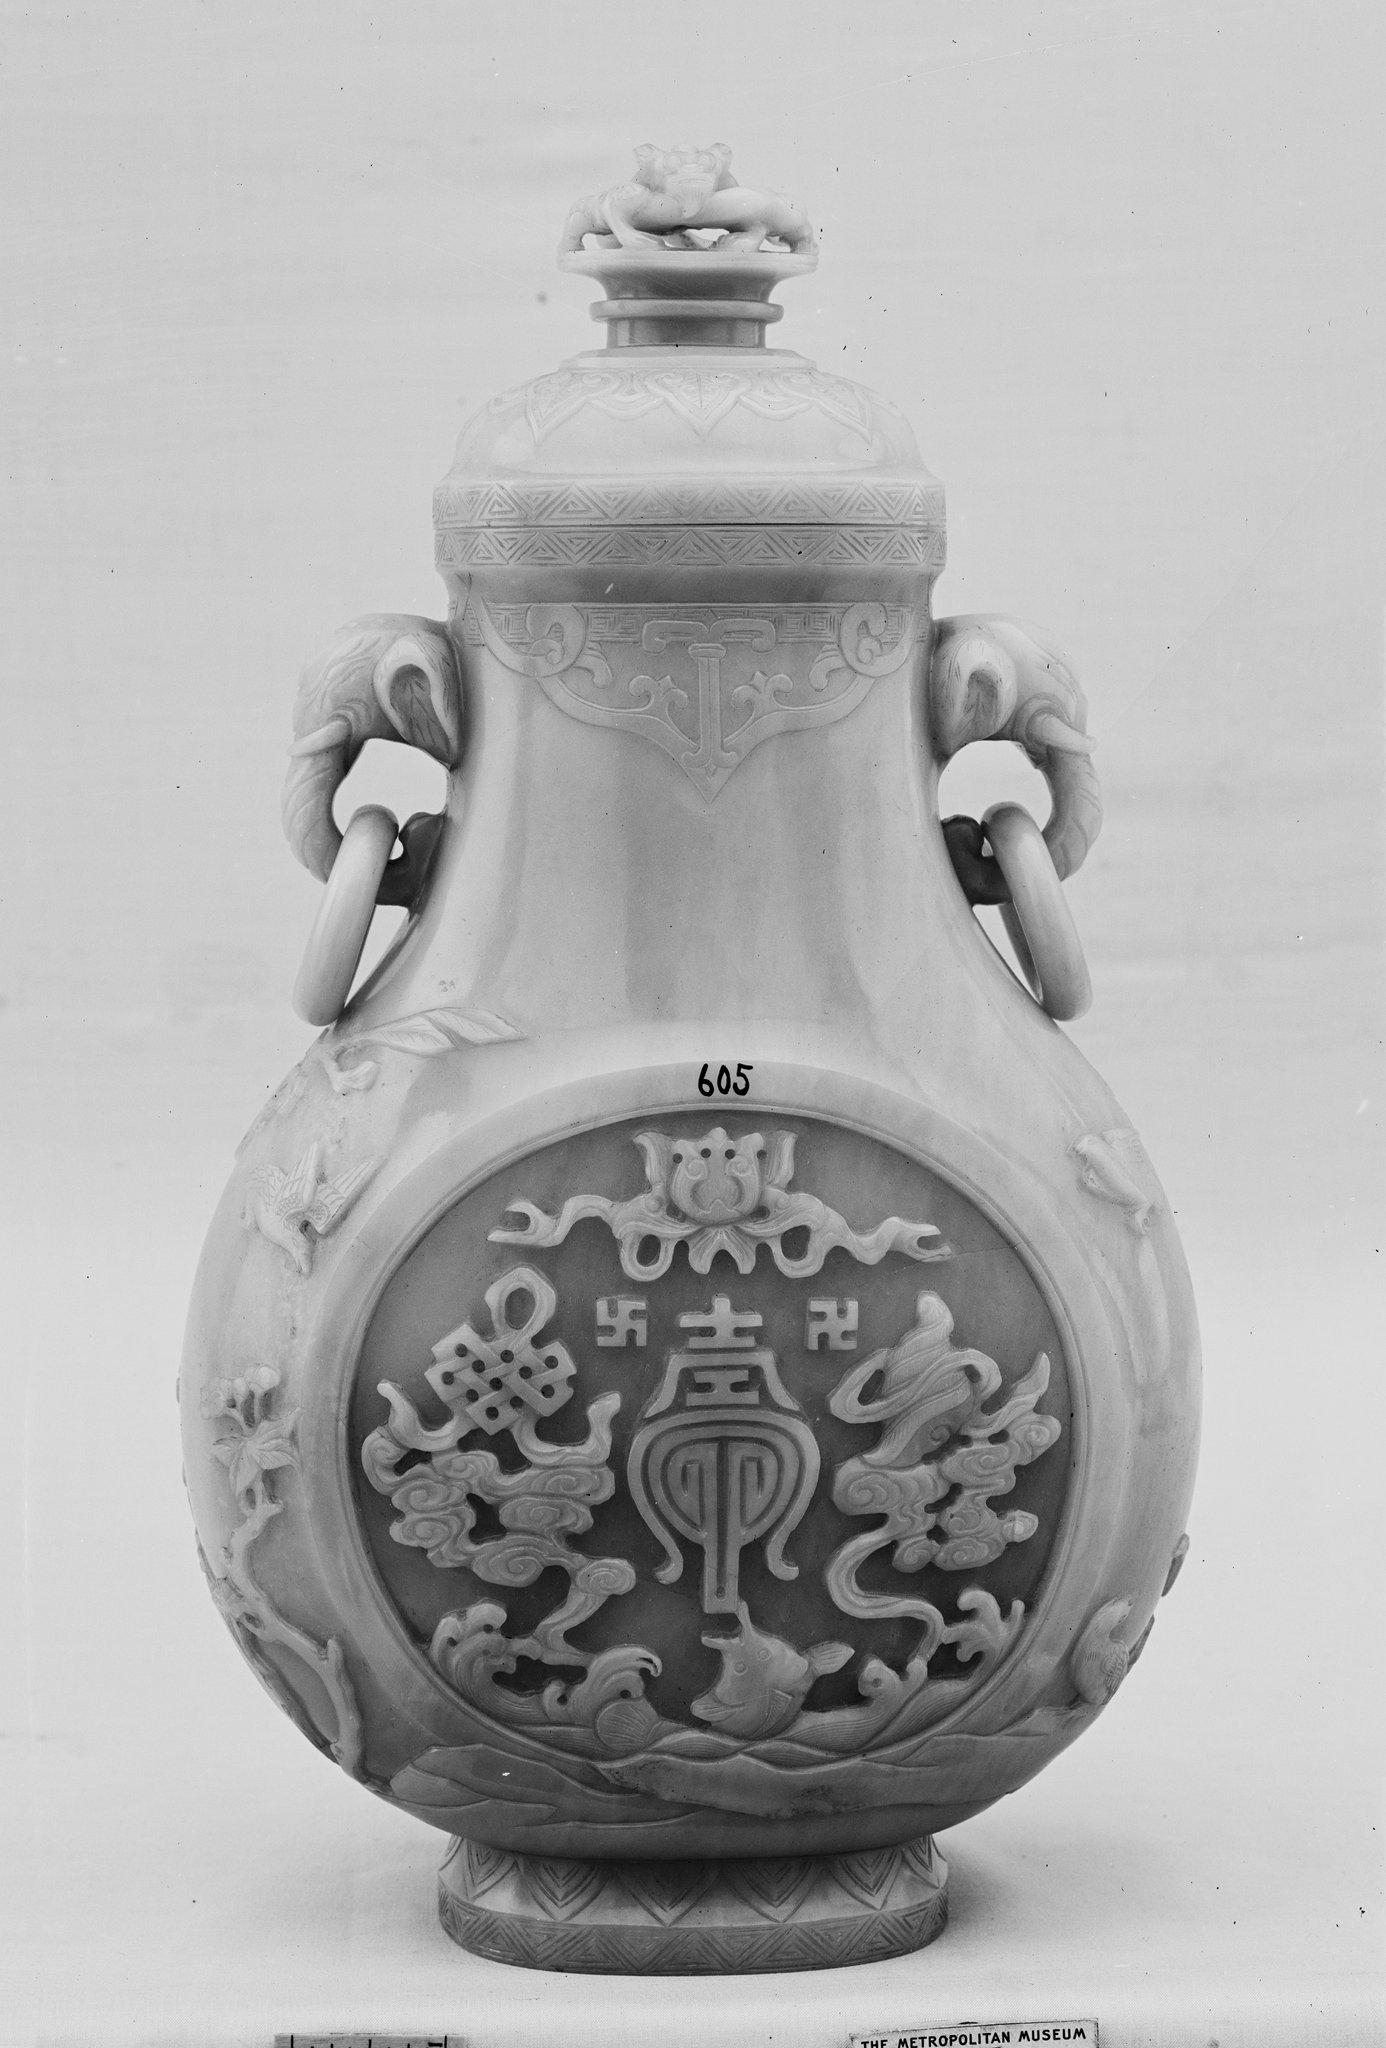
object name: covered vase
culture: chinese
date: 1701-1800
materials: jade